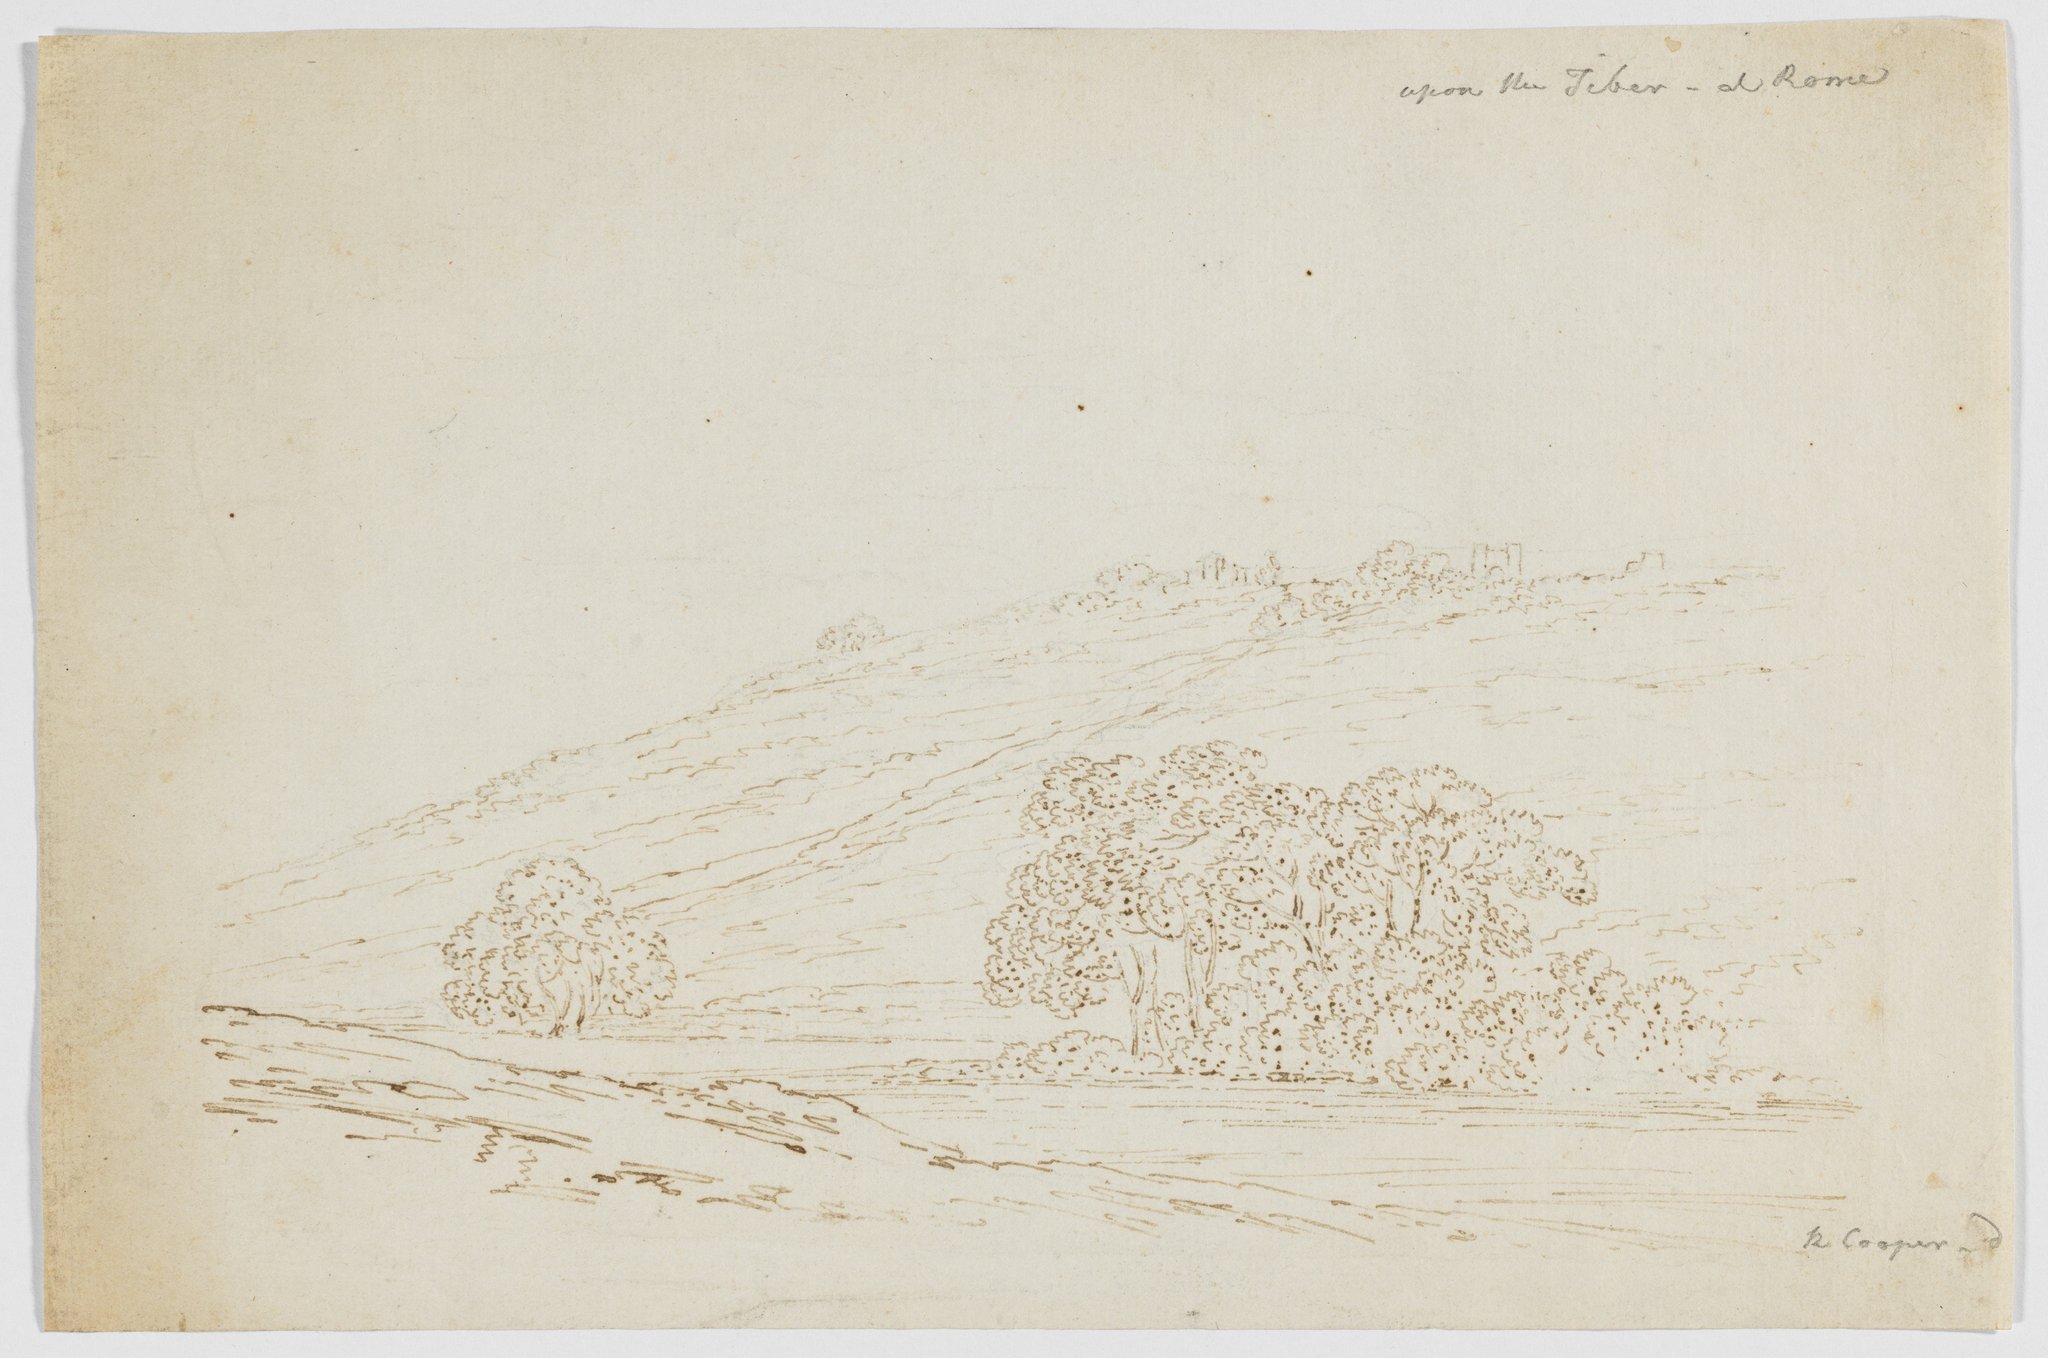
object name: drawing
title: Upon the Tiber, at Rome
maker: richard cooper ii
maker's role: artist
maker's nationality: british, scottish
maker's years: 1740-1822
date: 1774-1775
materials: graphite, ink, iron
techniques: printmaking, drawing